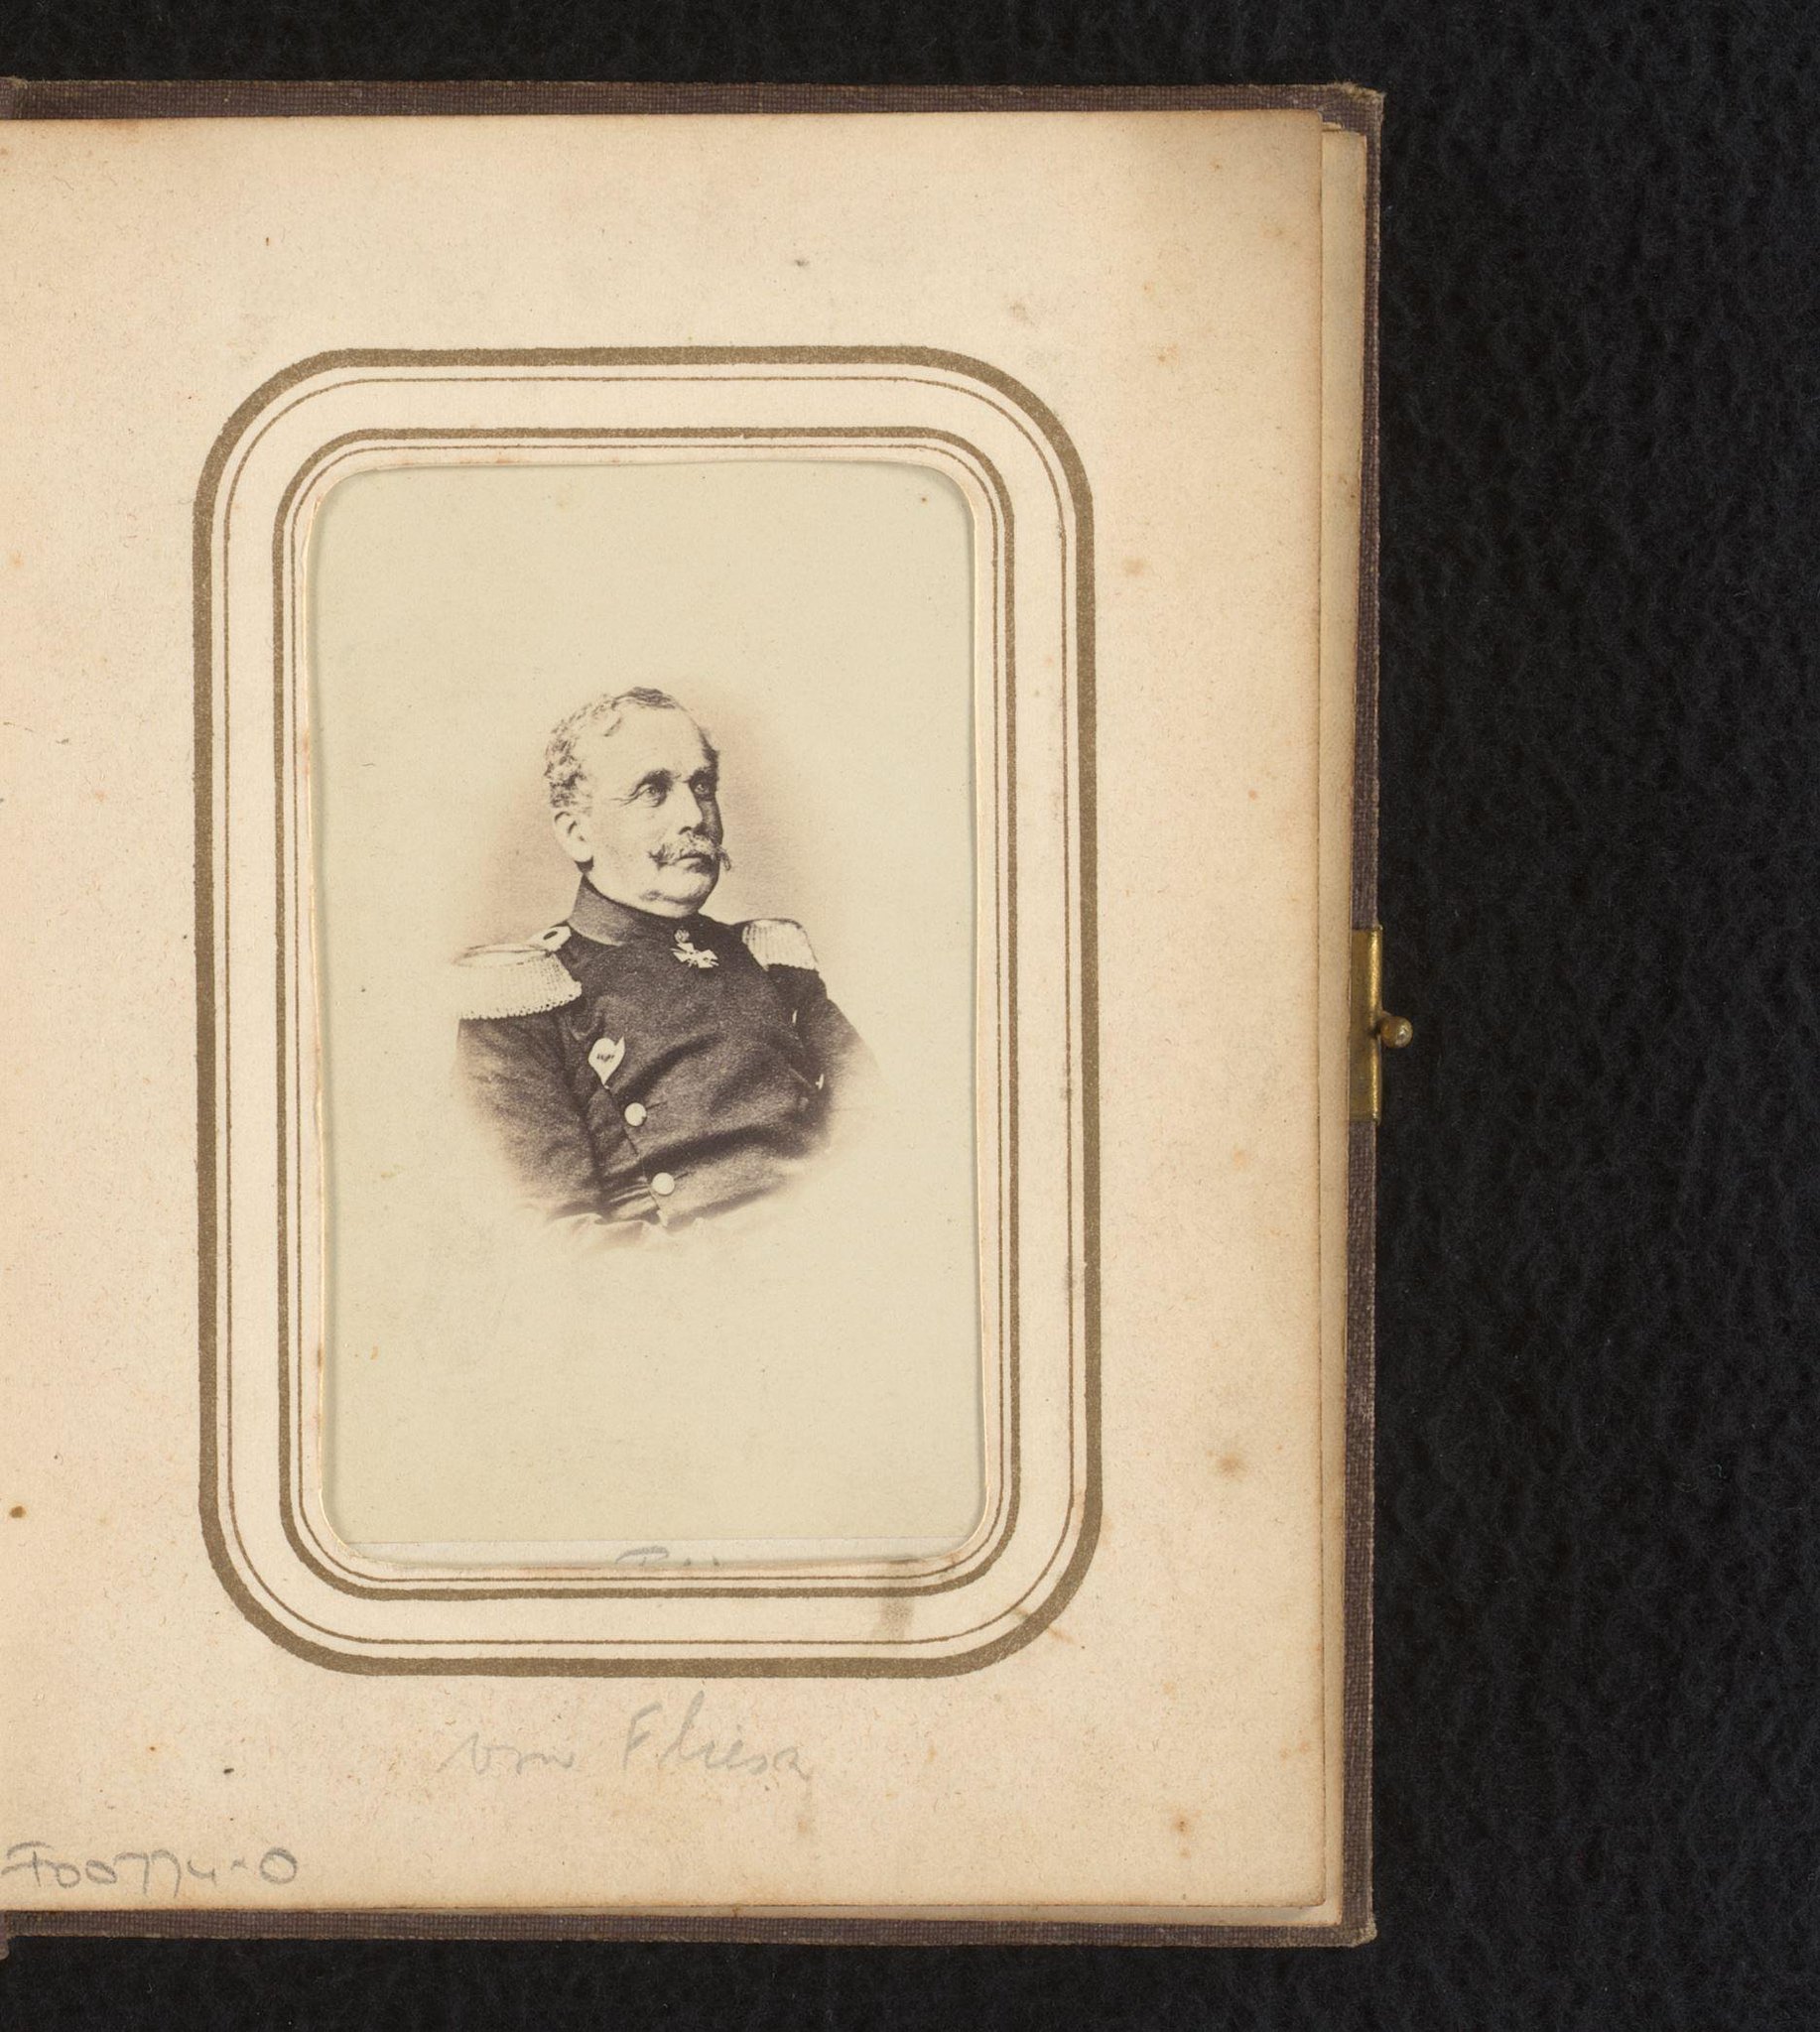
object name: photograph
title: Portret van Eduard Moritz von Flies in uniform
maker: Anonymous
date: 1860-1880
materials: cardboard, photographic support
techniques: albumen print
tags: historical persons, (military) uniforms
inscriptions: name: ‘v. Flies’, name: ‘von Flies’